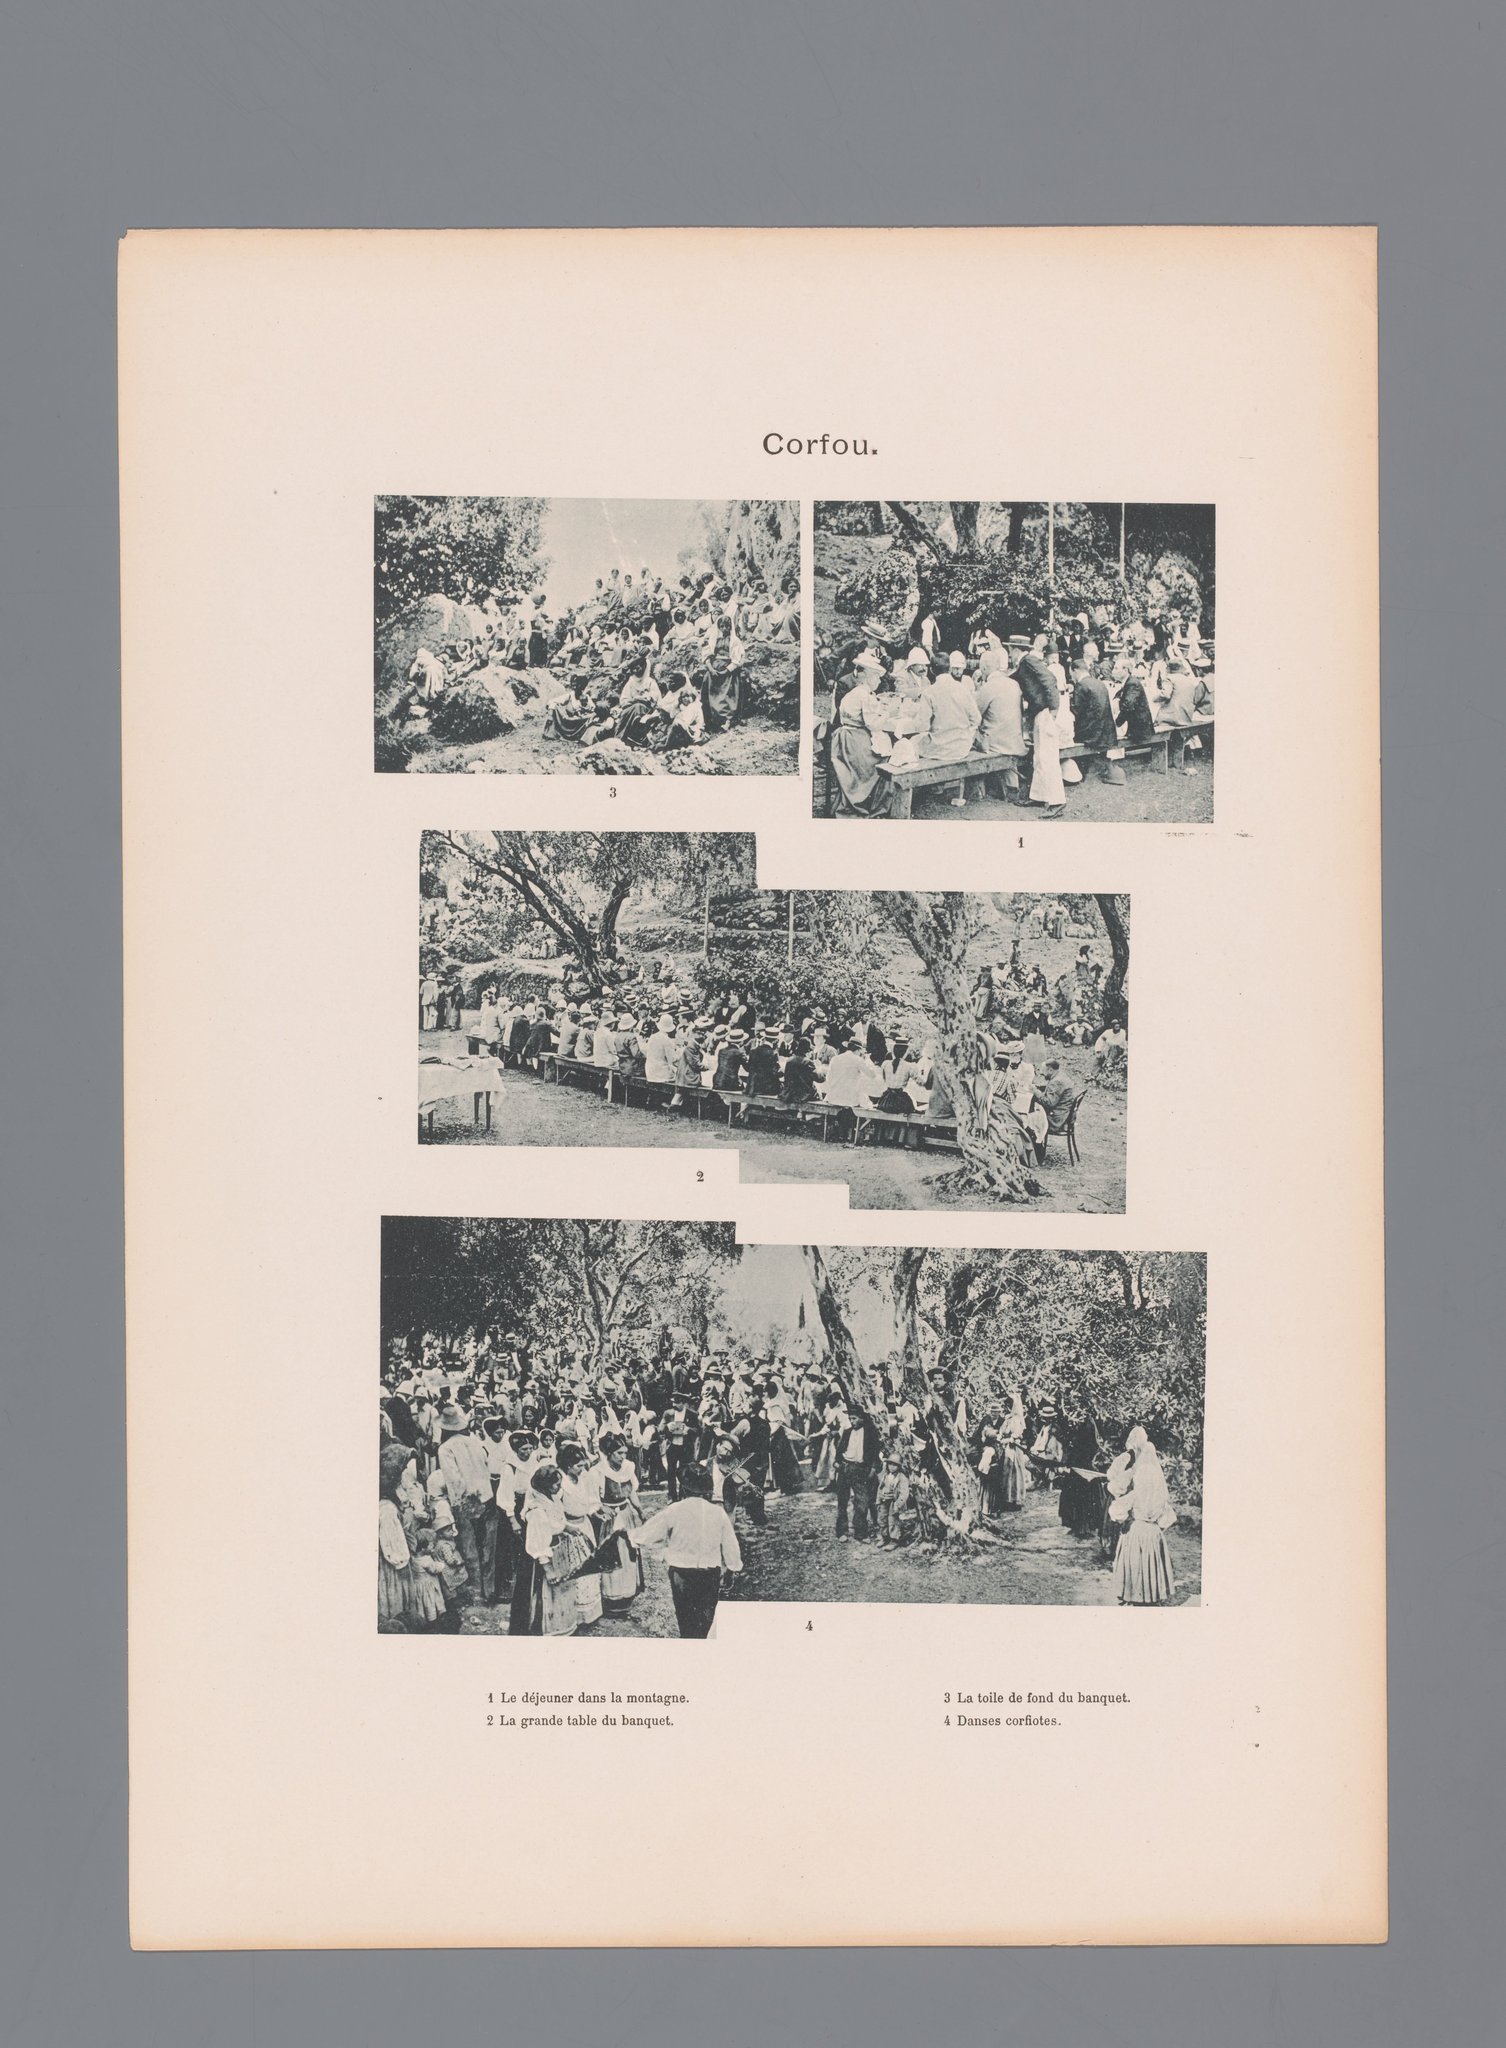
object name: photomechanical print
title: Vier afbeeldingen van een feest op Korfoe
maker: Anonymous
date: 1893-1898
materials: paper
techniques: photograph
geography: corfu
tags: celebration meal, feast, banquet - cc - out of doors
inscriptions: inscription: ‘1 Le déjeuner dans la montagne./ 2 La grande table du banquet./ 3 La toile de fond du banquet./ 4 Danses corfiotes.’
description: Deze prenten maken deel uit van een omslag met 103 prenten op 16 bladen en een titelblad.